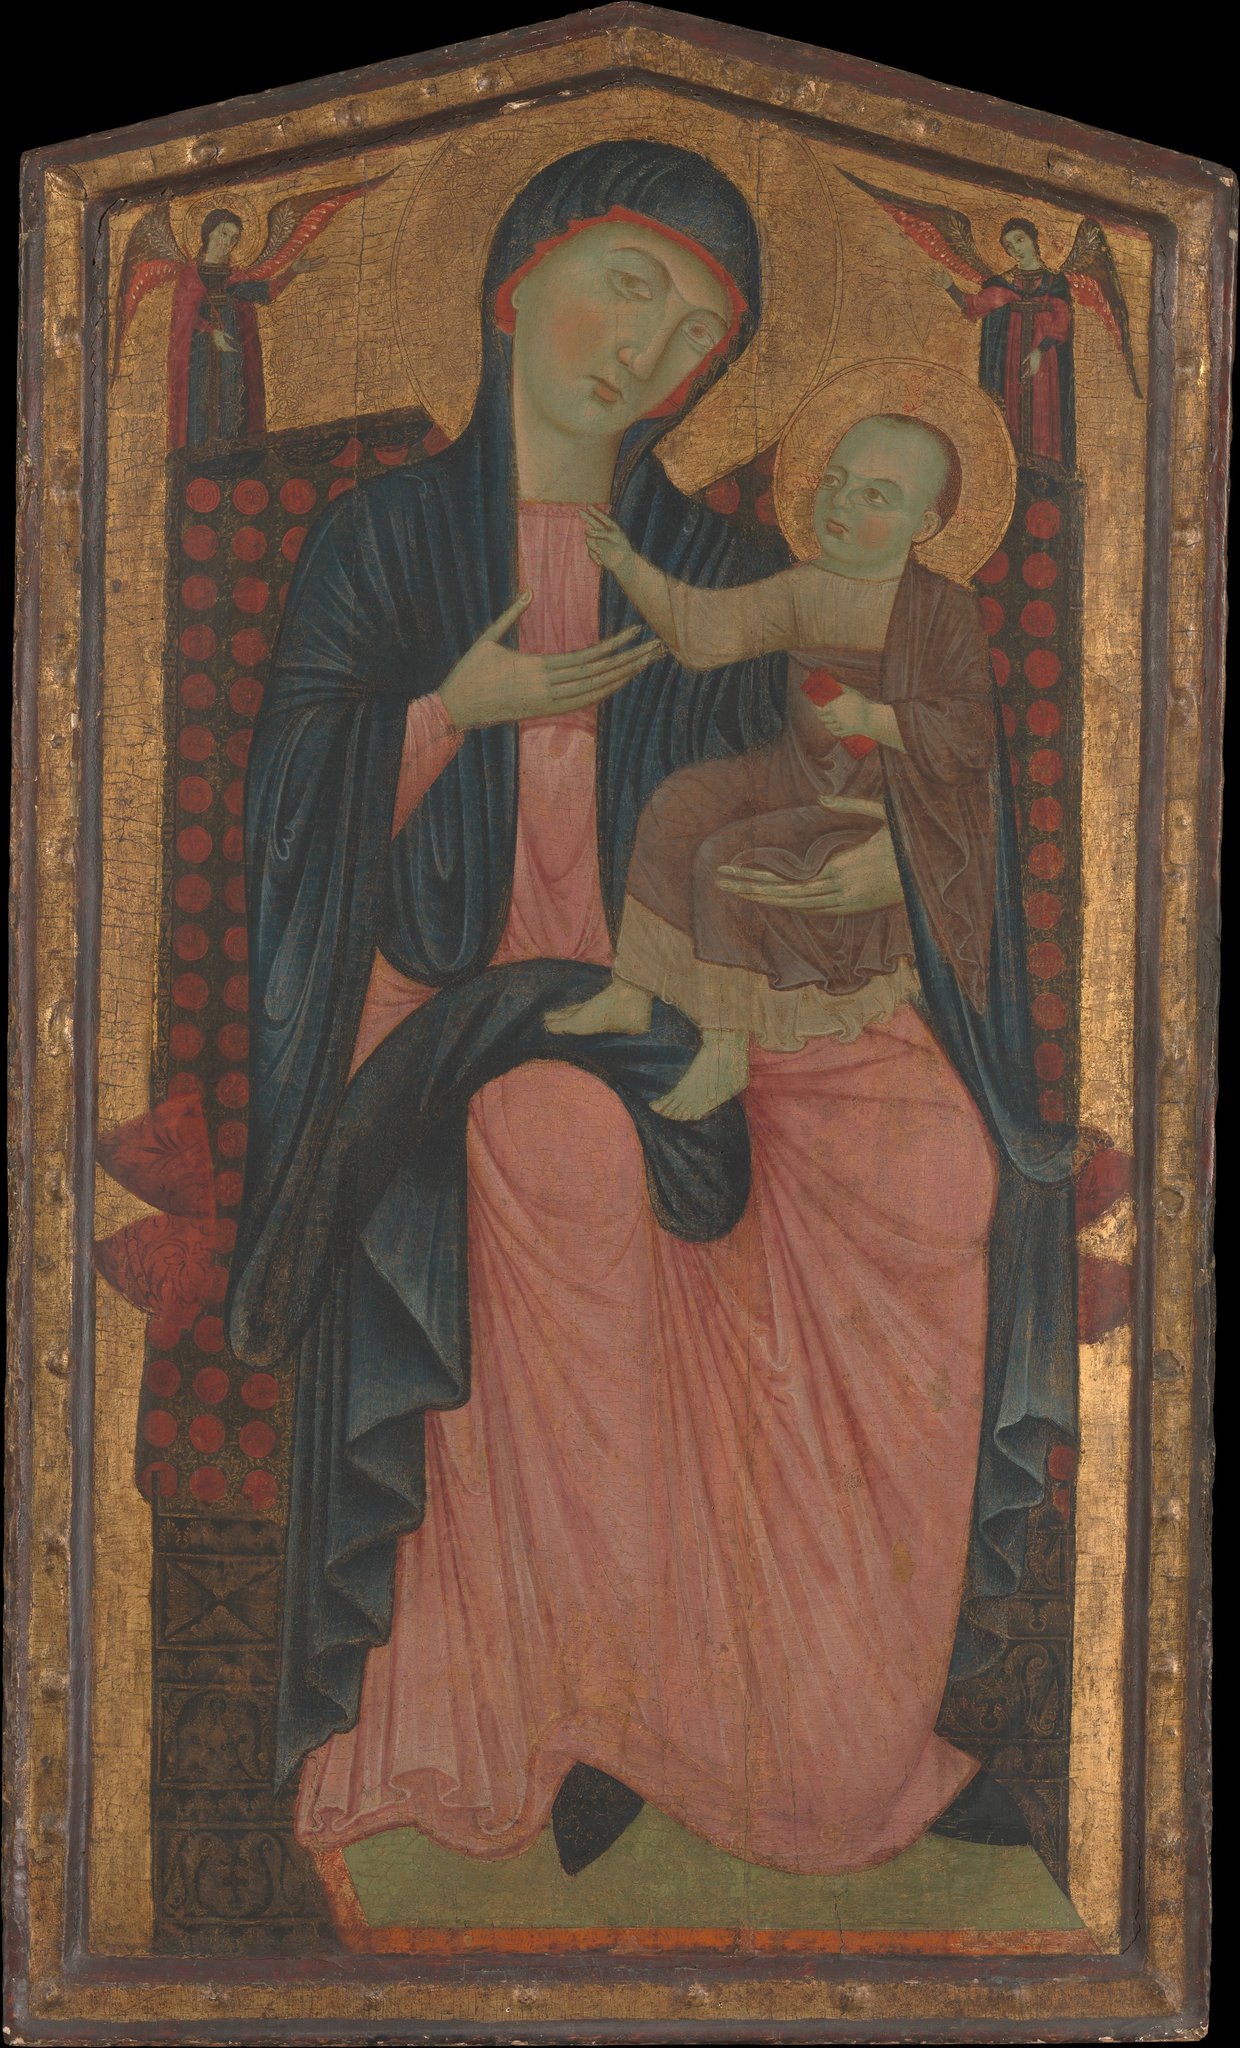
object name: painting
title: Madonna and Child Enthroned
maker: master of the magdalen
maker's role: artist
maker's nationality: italian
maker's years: 1265-1295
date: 1270-1299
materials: gold leaf, paint, wood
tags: angels,madonna and child